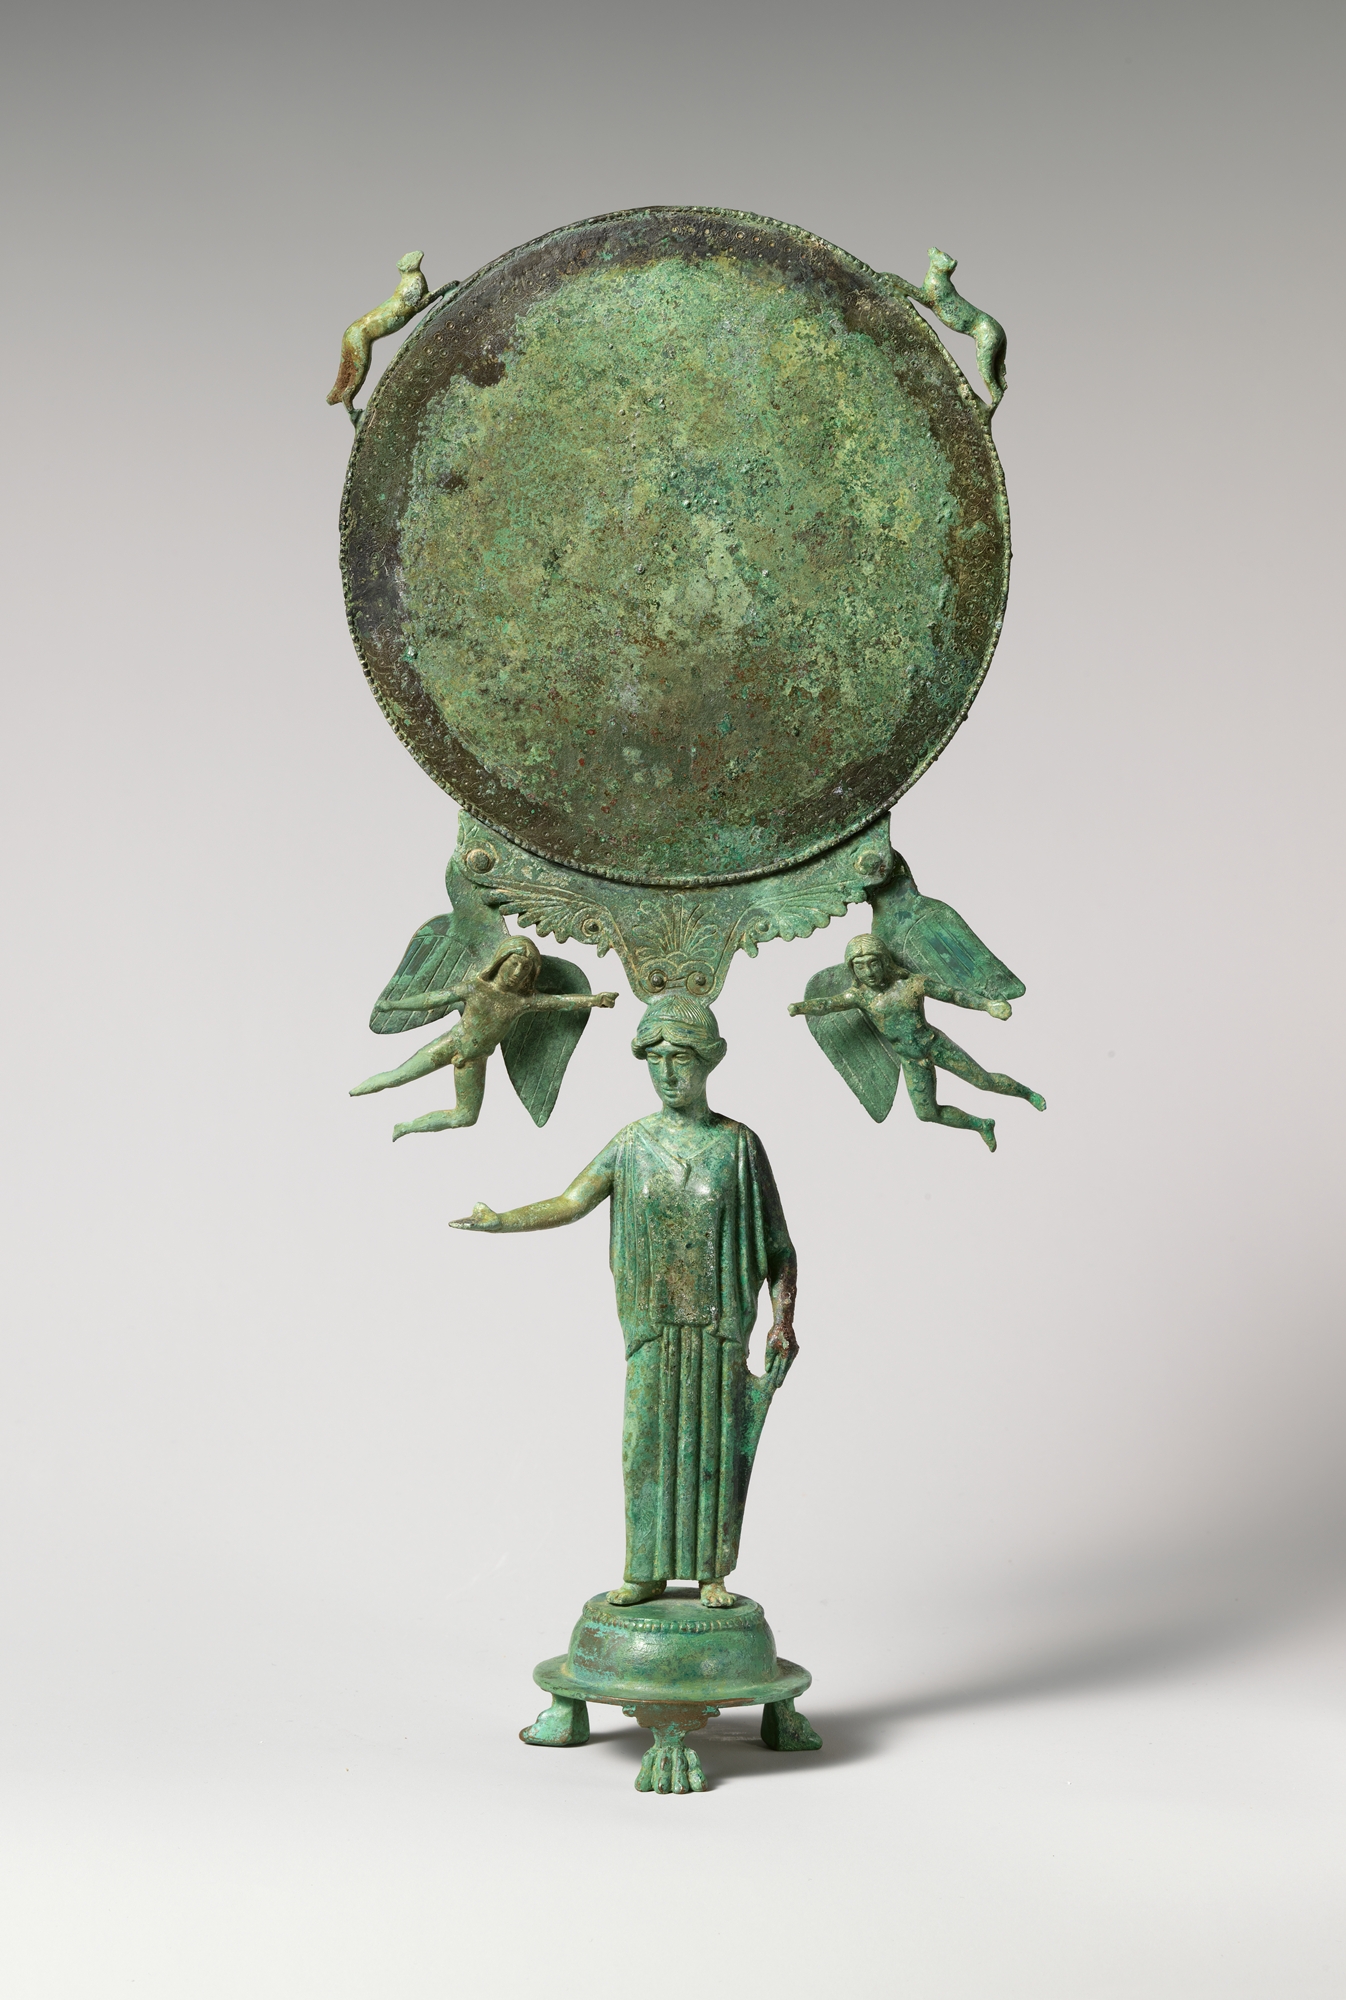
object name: mirror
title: Bronze mirror with a support in the form of a draped woman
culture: greek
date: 467-435 BCE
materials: bronze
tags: women,eros